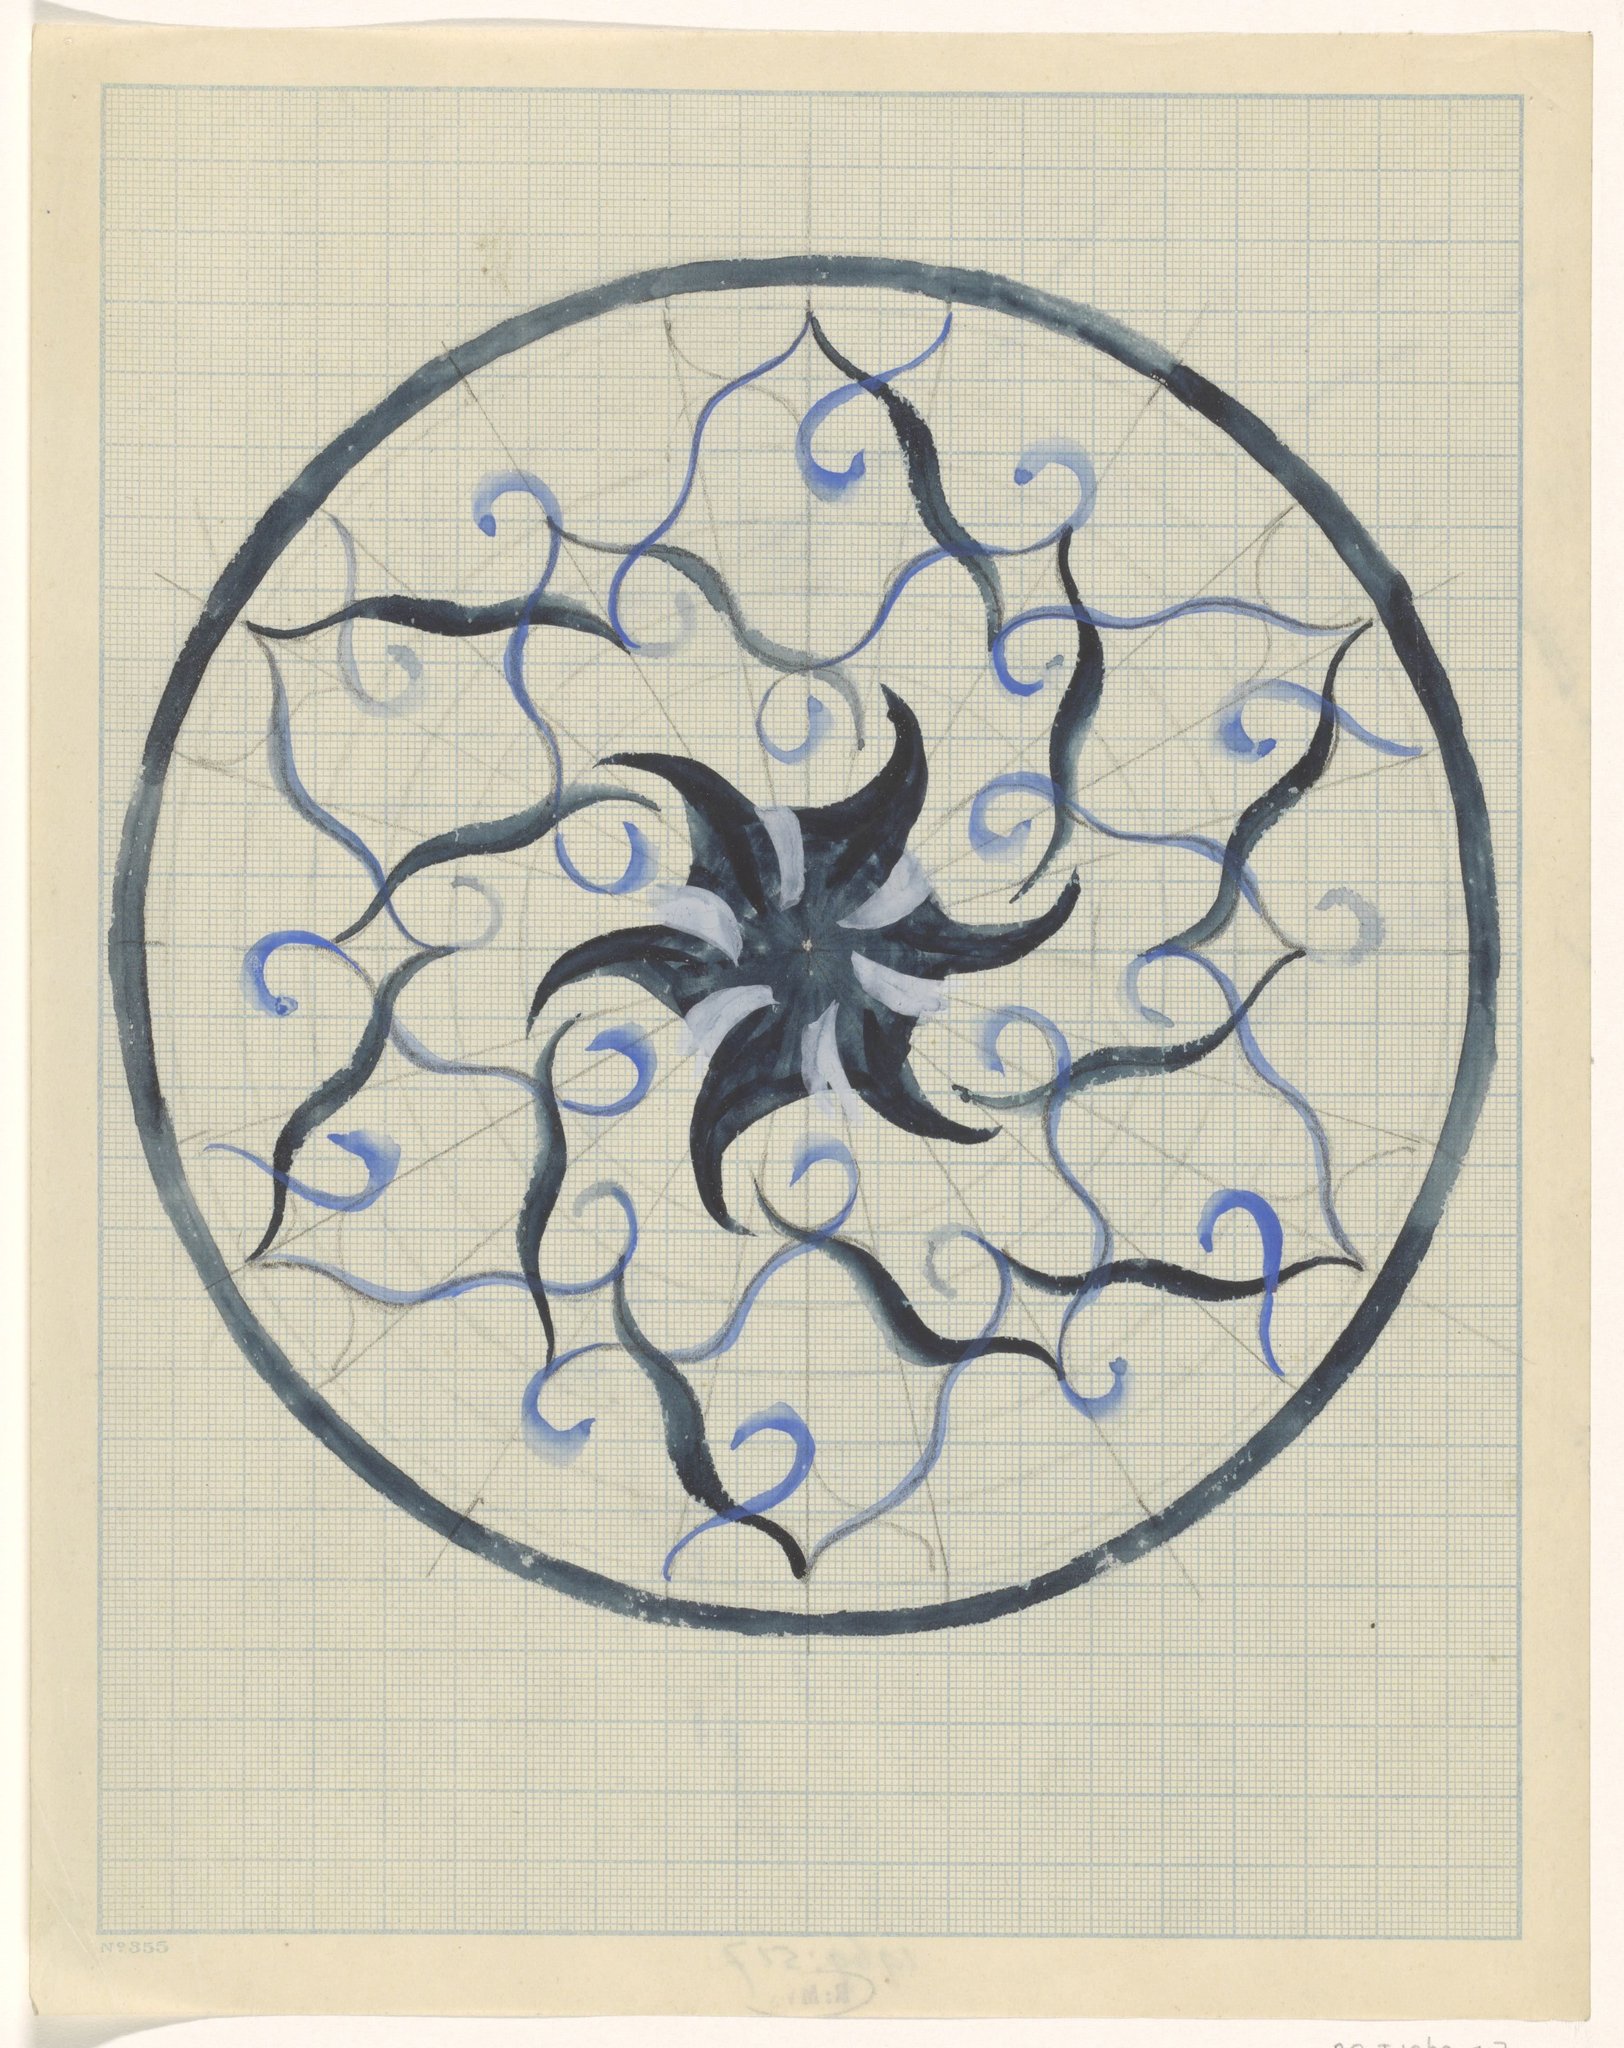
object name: design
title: Ontwerp voor een bord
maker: carel adolph lion cachet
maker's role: draughtsman, print maker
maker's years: 1864-1945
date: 1874-1945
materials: pencil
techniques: brush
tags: work of applied art (+ ceramics ~ arts), dish, plate, saucer